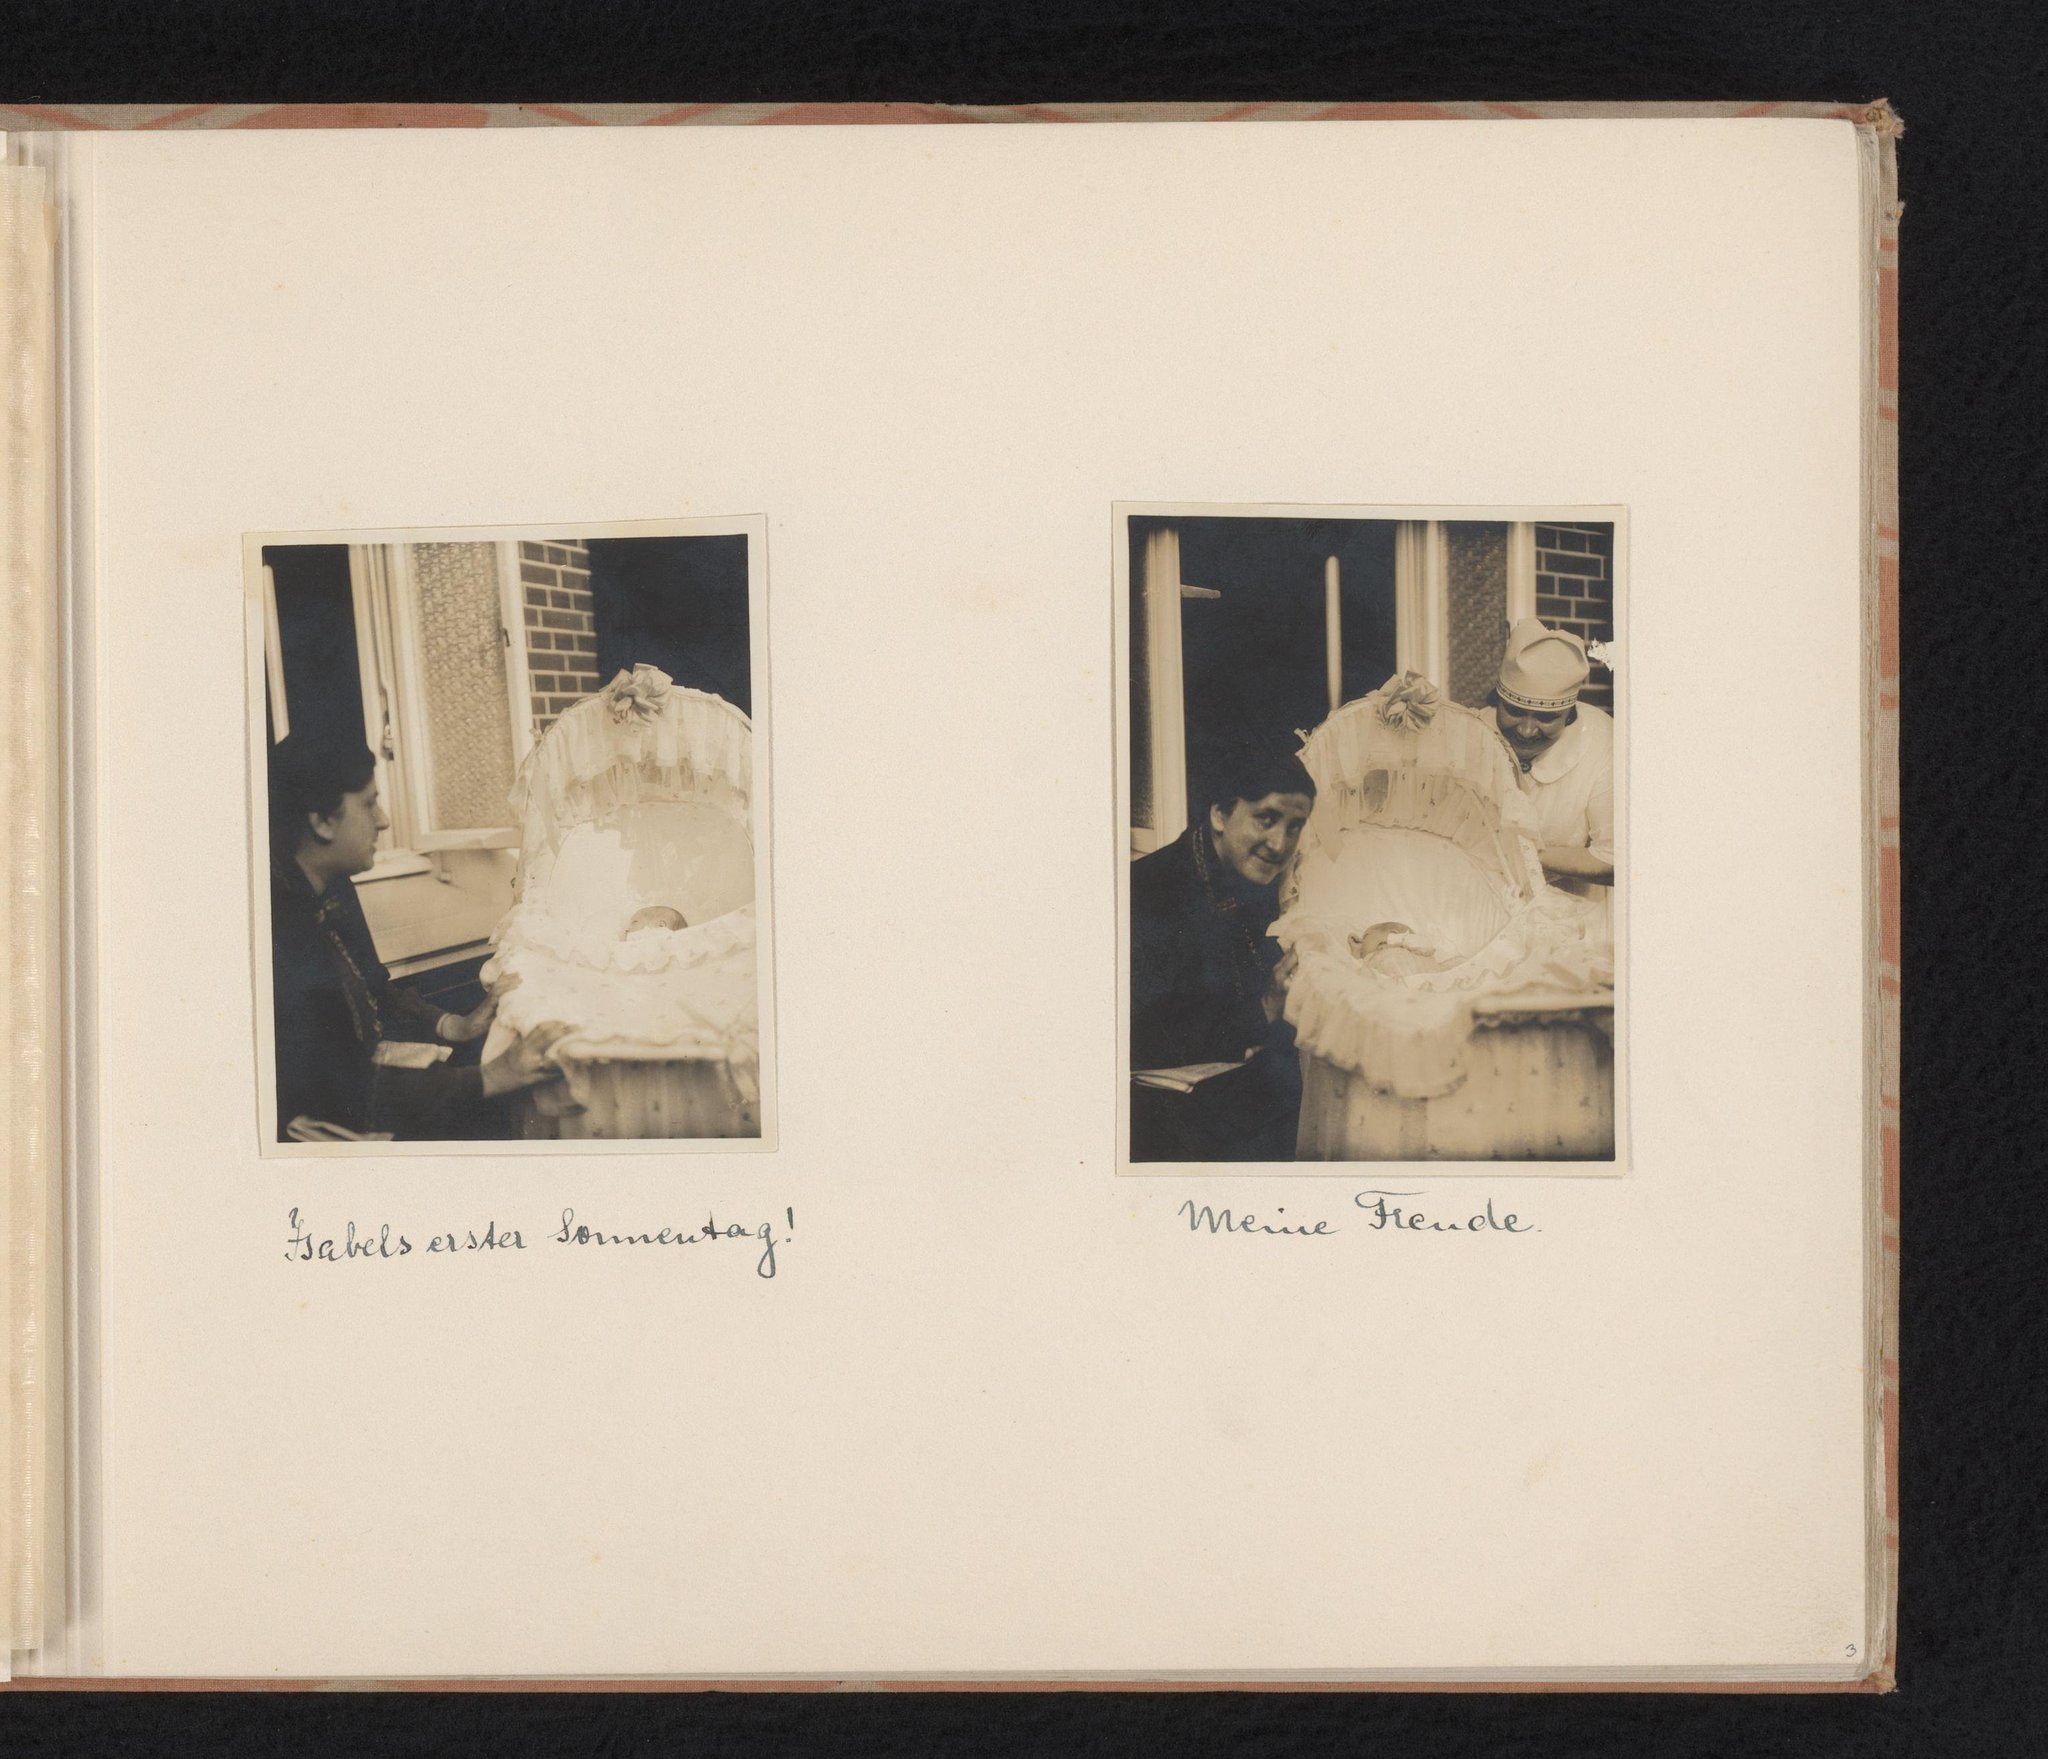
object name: photograph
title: Isabel Wachenheimer met haar moeder Else Wachenheimer-Moos en een onbekende verpleegster tijdens Isabel's eerste dag in de zon, juni-juli 1928, Hamburg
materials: paper, photographic support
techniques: gelatin silver print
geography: hamburg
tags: else wachenheimer-moos, leiden, isabel wachenheimer-elon, family life at home, mother and baby or young child, infant, baby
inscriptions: inscription: ‘Isabel erster Sonnentag!//Meine Freunde’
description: Albumblad met twee foto's. Op de linker Else Wachenheimer-Moos (links) en Isabel Wachenheimer (rechts); op de rechter Else Wachenheimer-Moos (links), Isabel Wachenheimer (midden) en onbekende verpleegster (rechts). Onderdeel van het fotoalbum met foto's van Isabel Wachenheimer als kind (1928-1931).